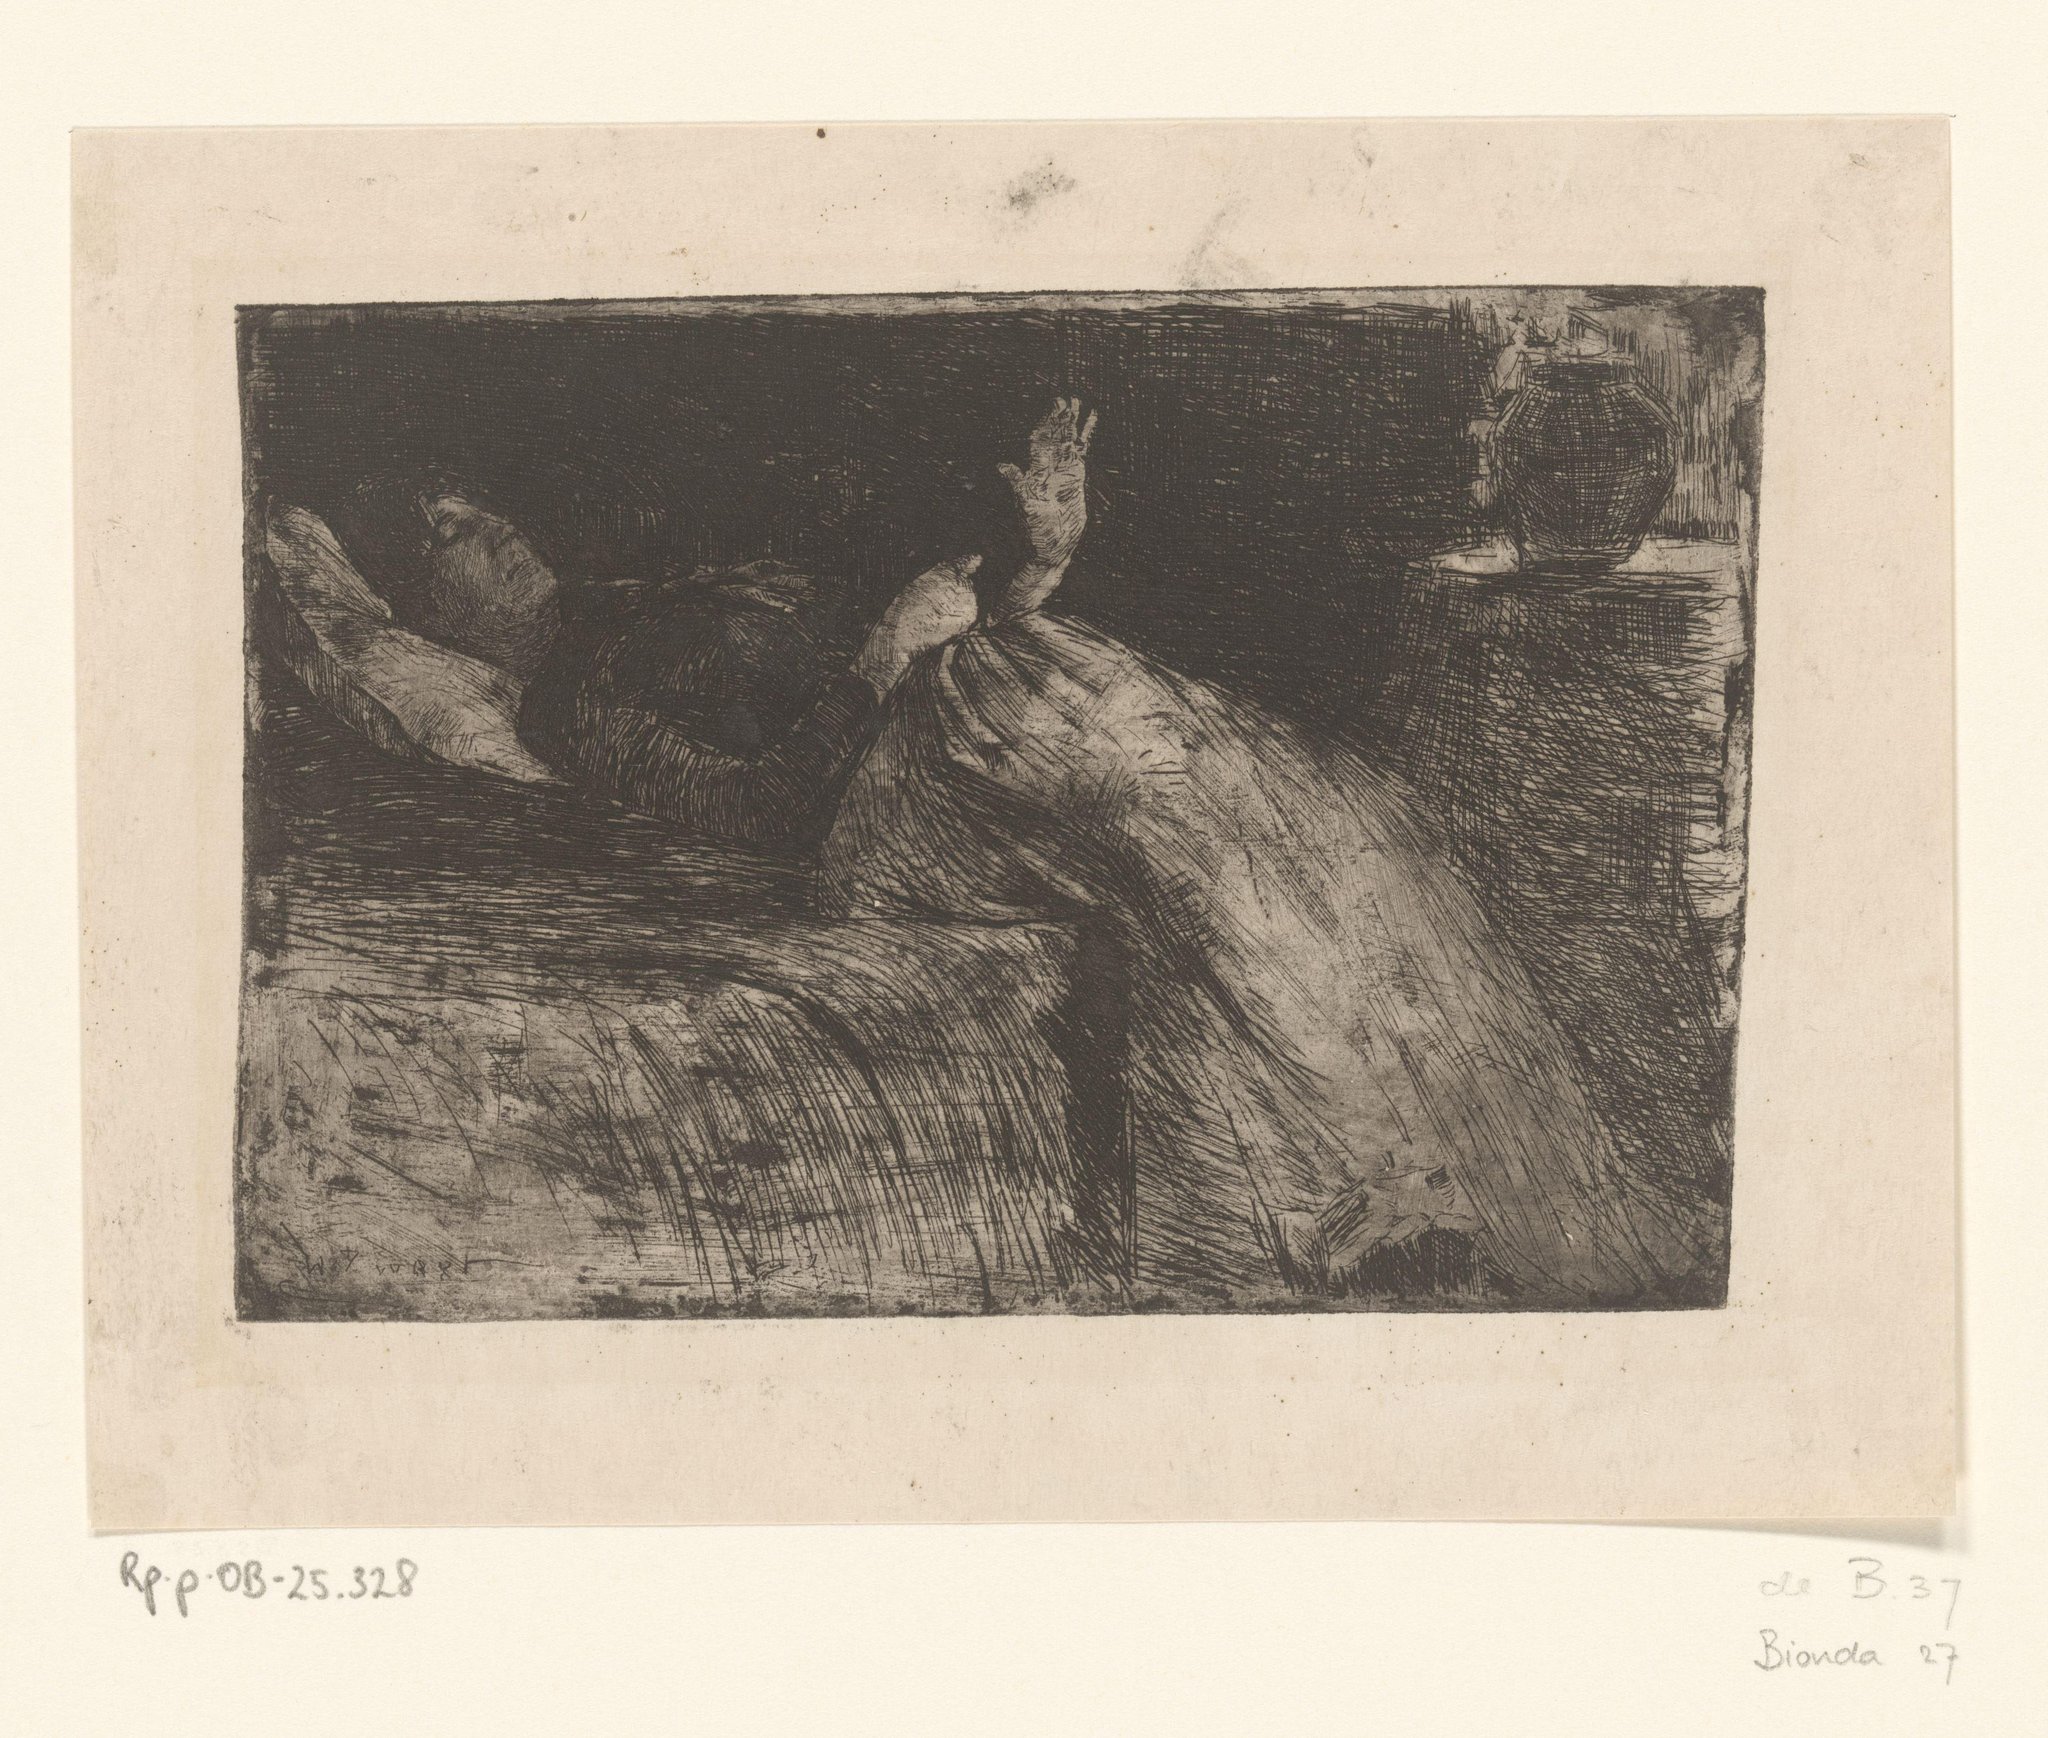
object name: print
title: Liggende vrouw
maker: willem de zwart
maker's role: draughtsman, painter, print maker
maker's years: 1862-1931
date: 1886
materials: paper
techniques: drypoint, etching, intaglio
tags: adult woman (+ lying)